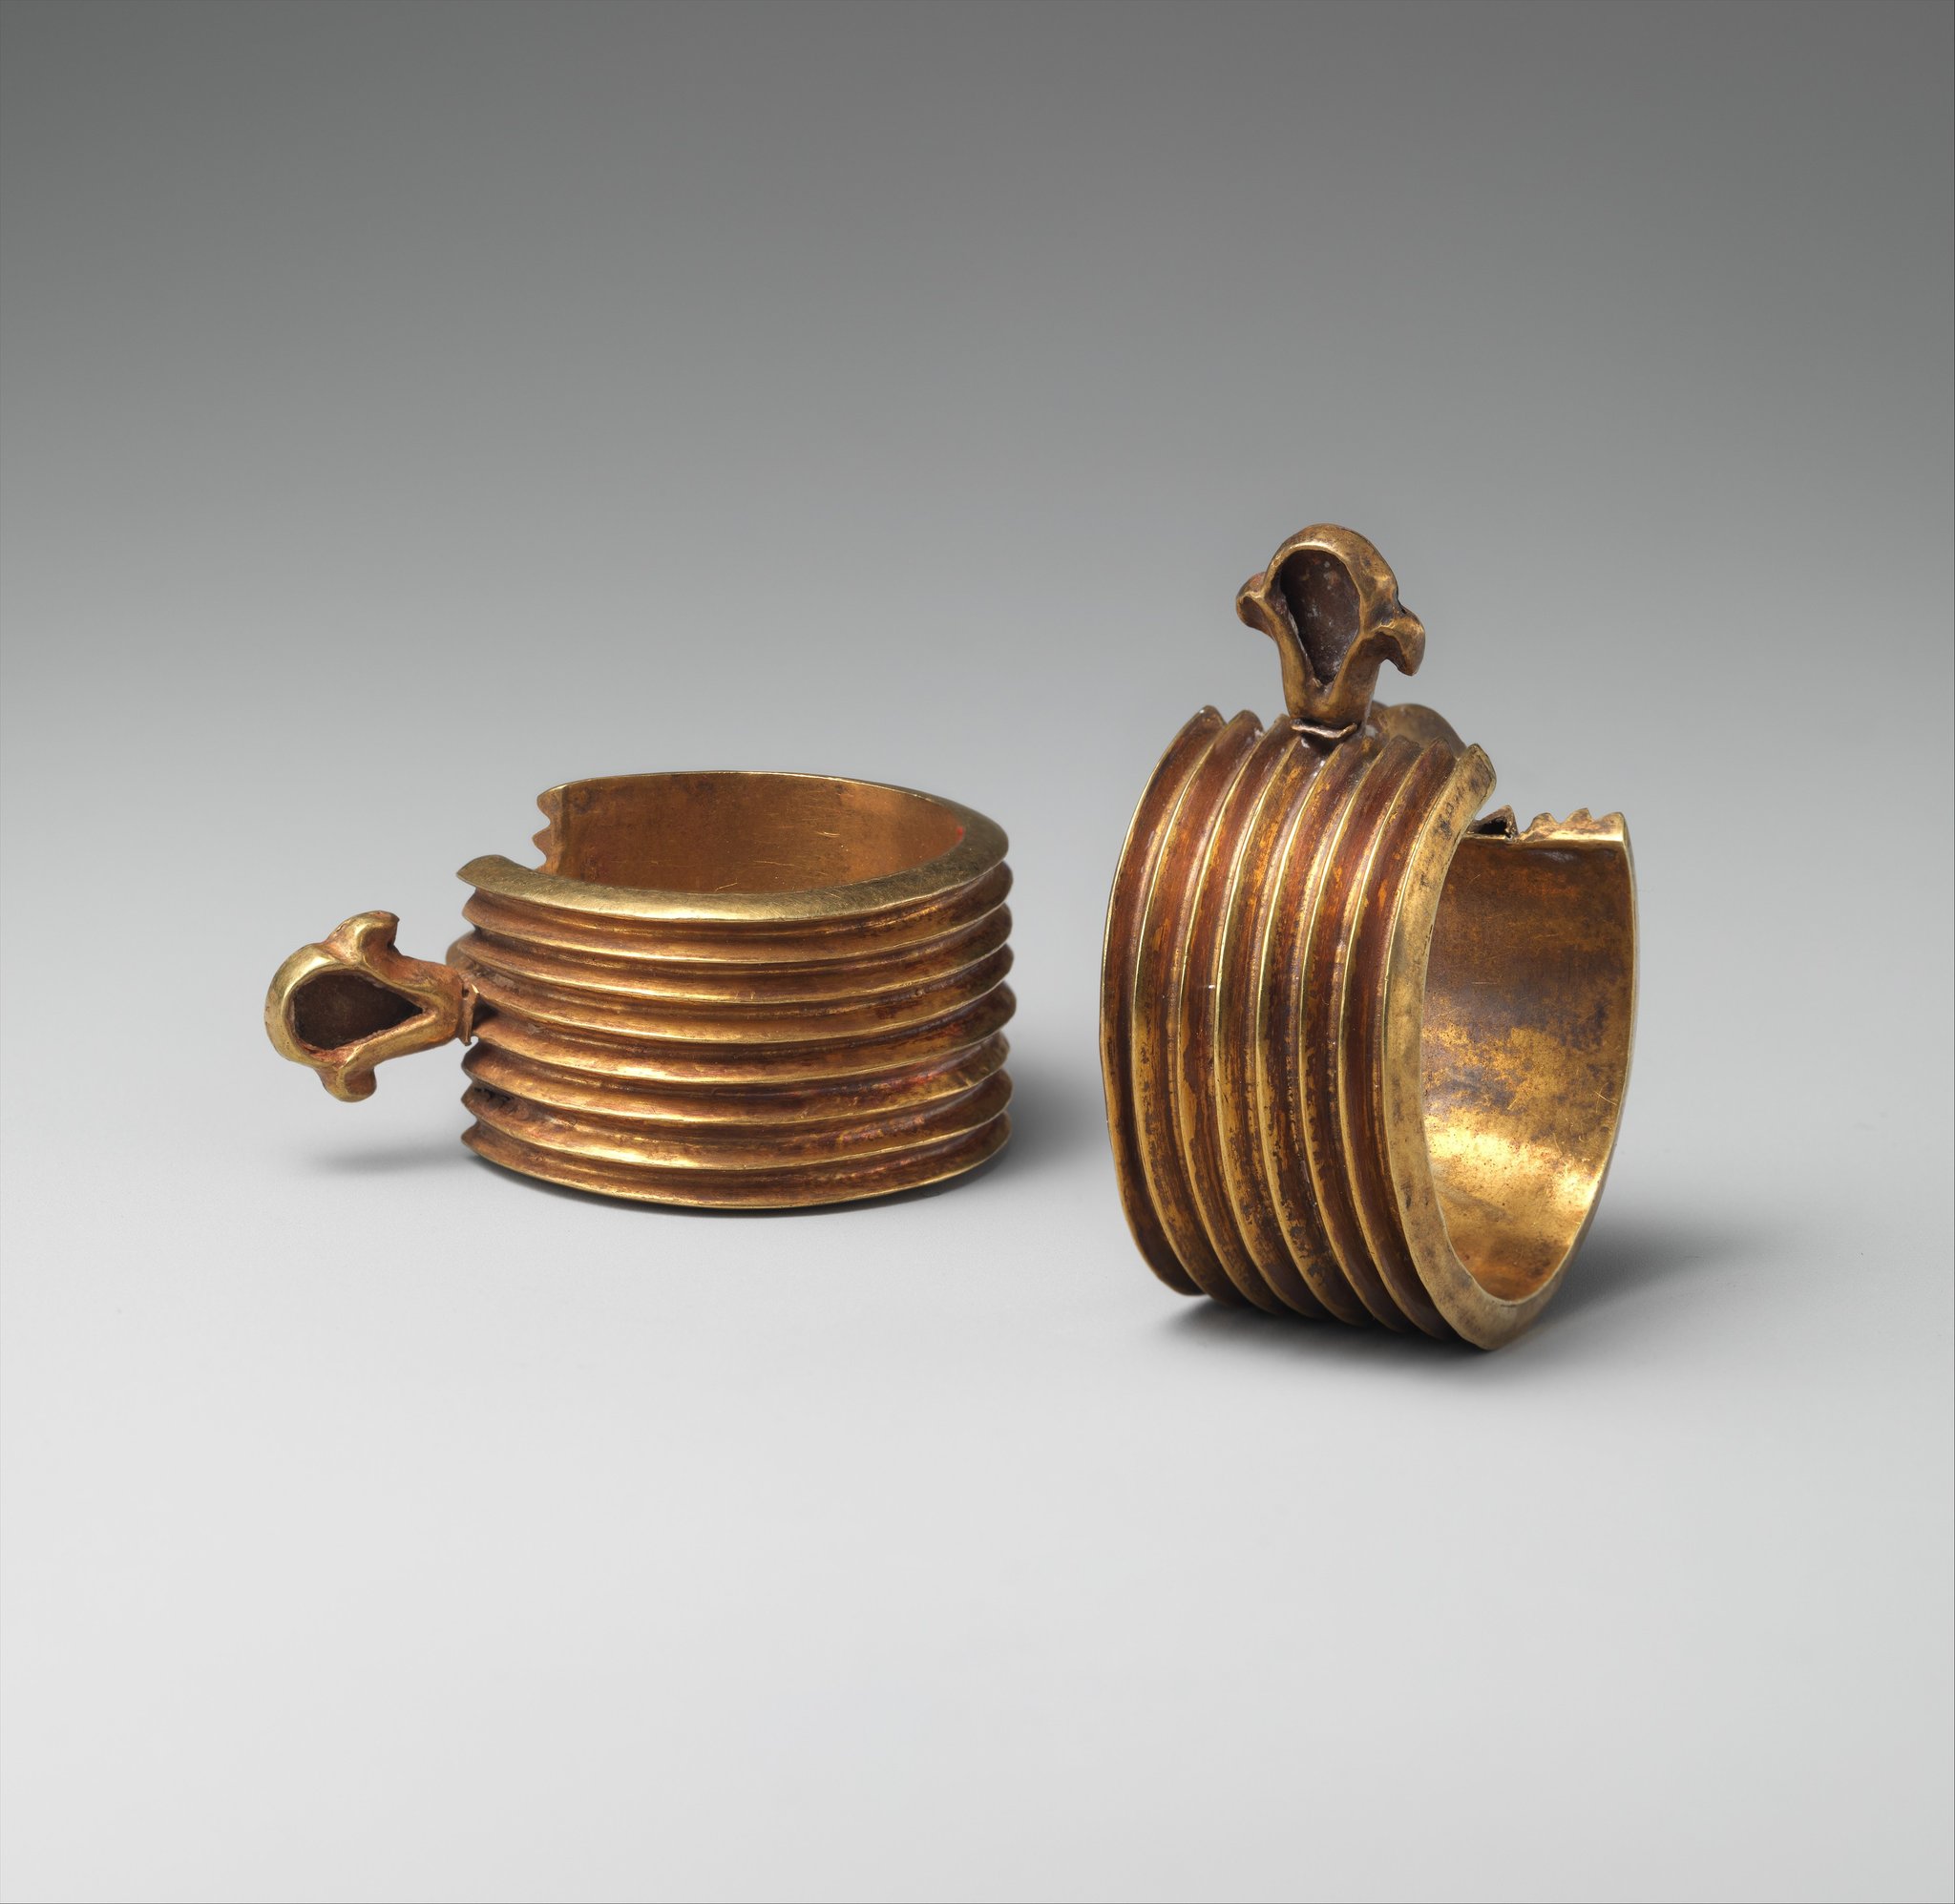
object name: earring, penannular, ribbed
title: Pair of Ribbed Penannular Earrings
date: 1479-1425 BCE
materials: gold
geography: egypt